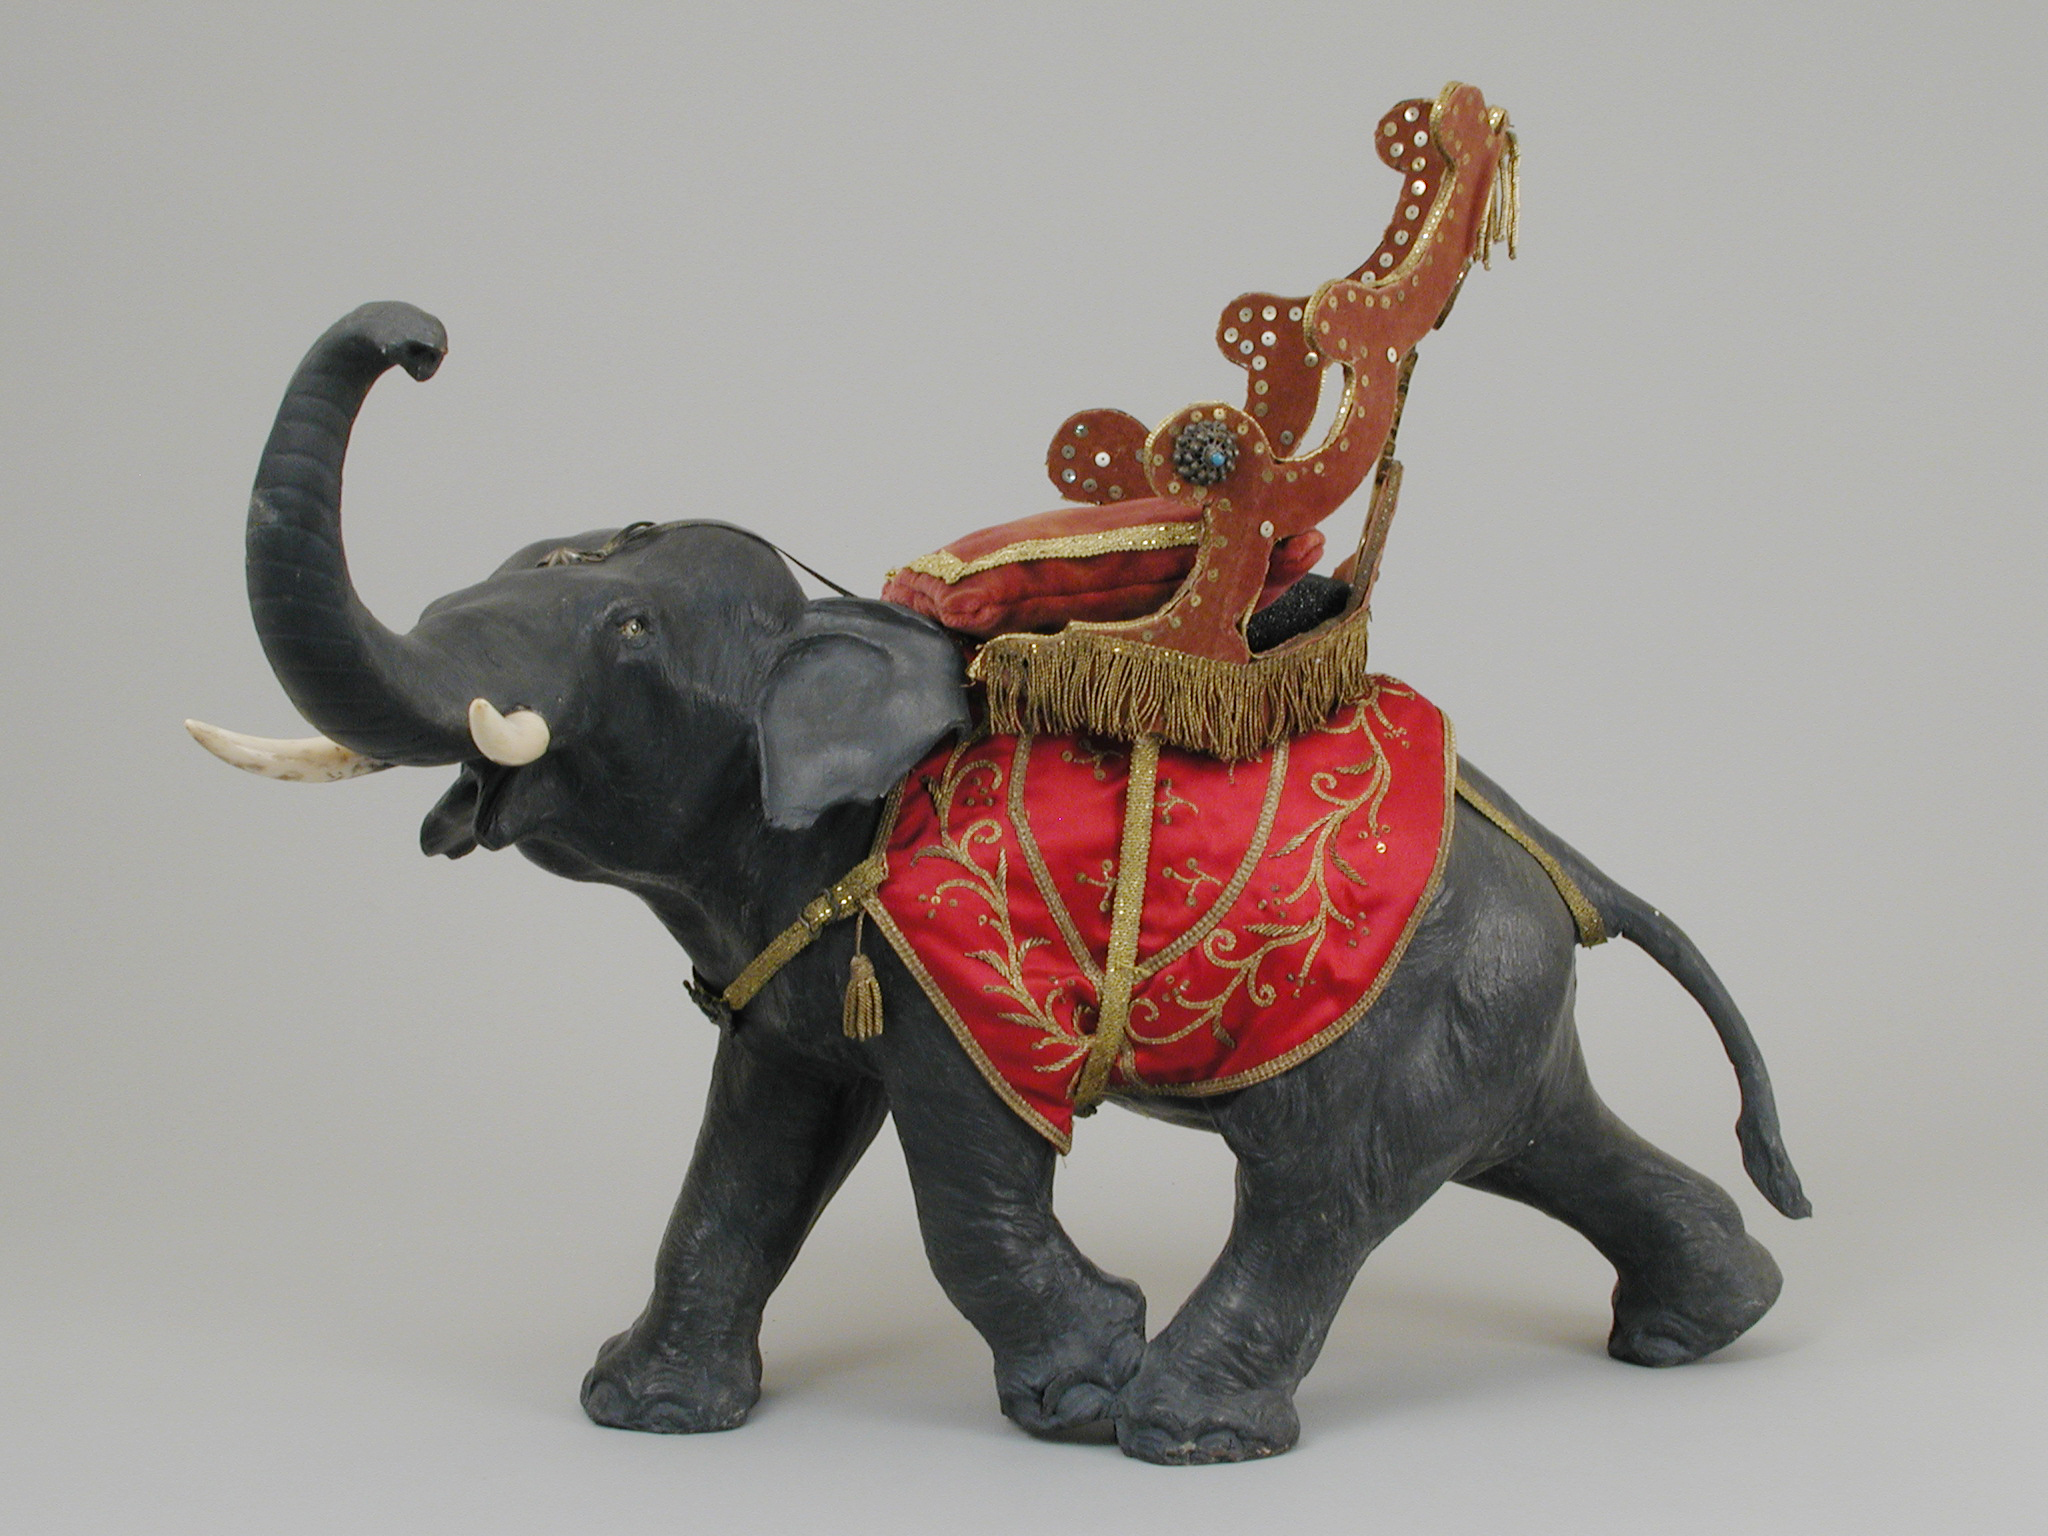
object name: crèche figure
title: Elephant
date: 1701-1900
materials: ivory, terracotta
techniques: polychrome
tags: elephants